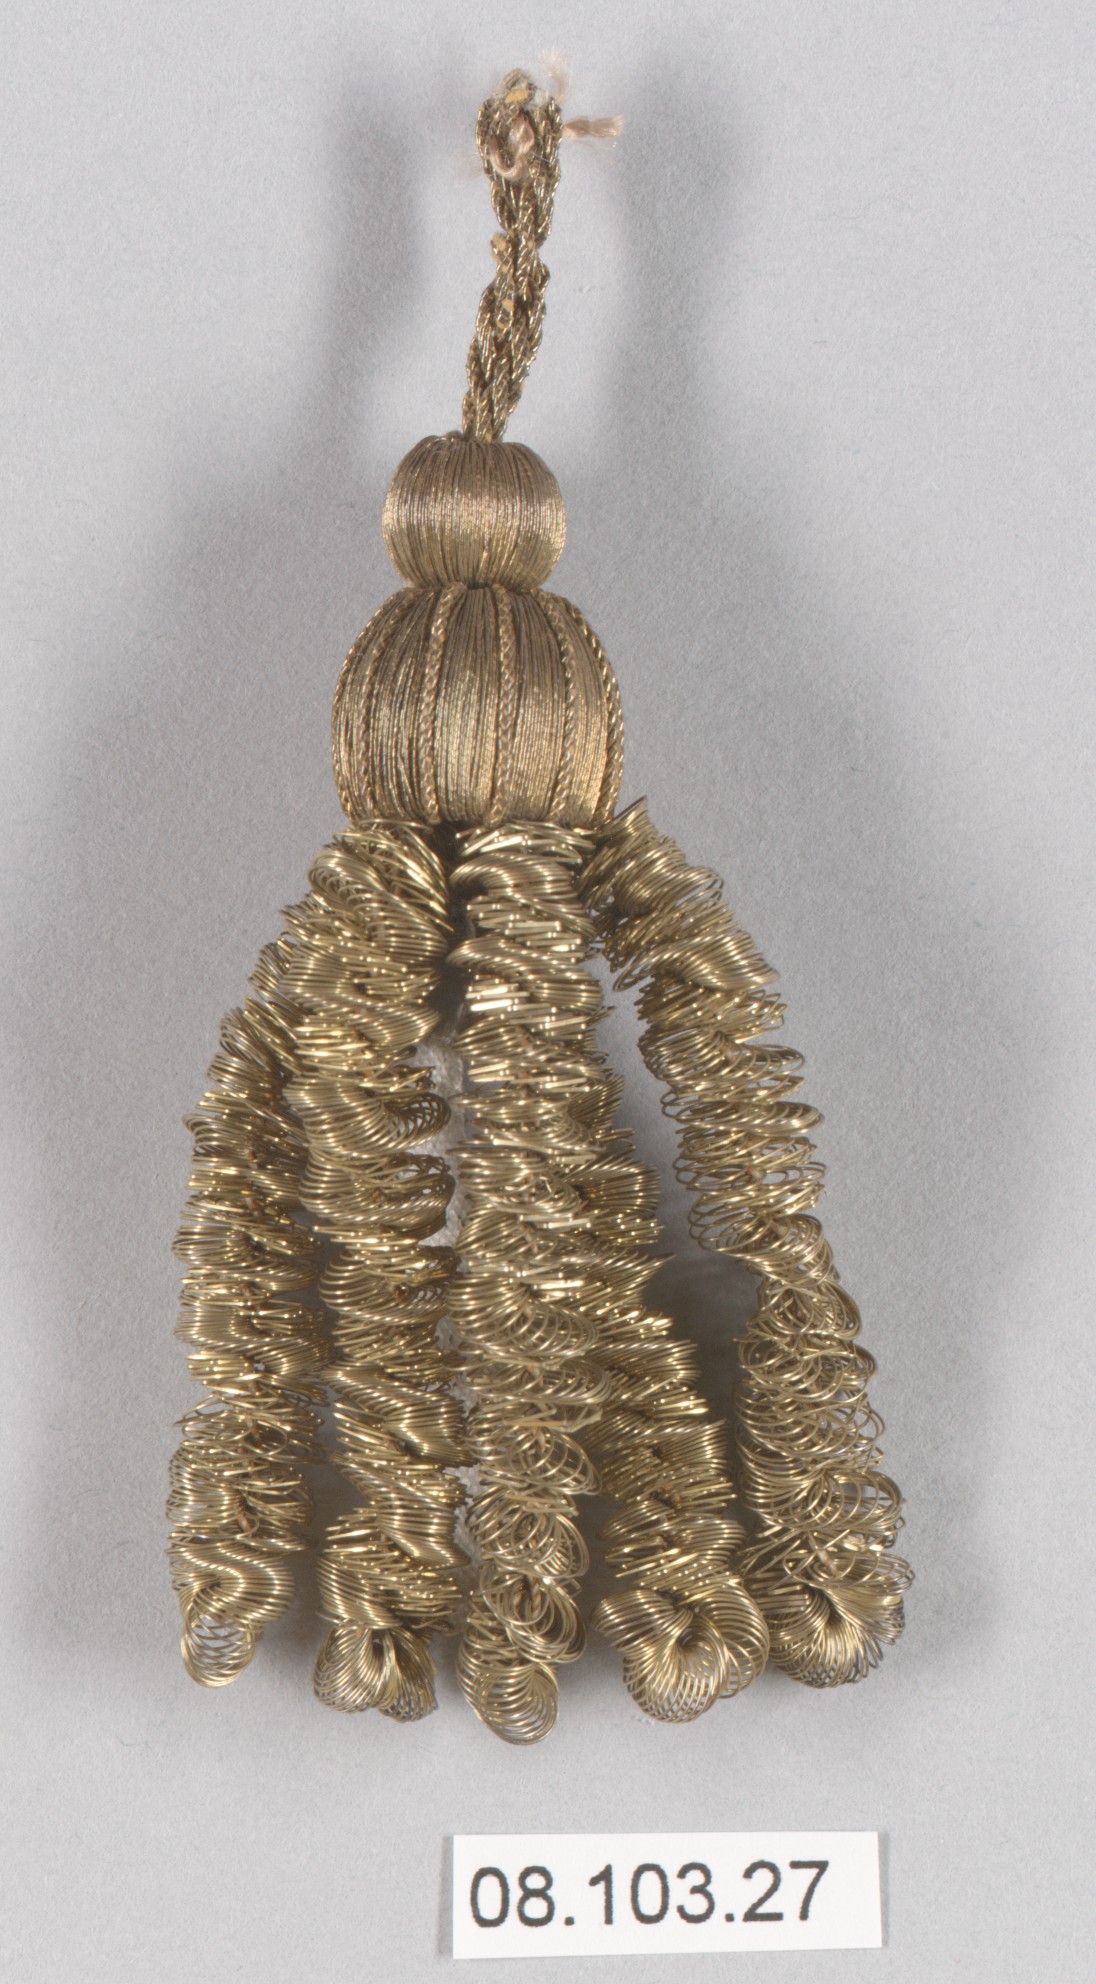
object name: tassel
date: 1701-1900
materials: metal thread